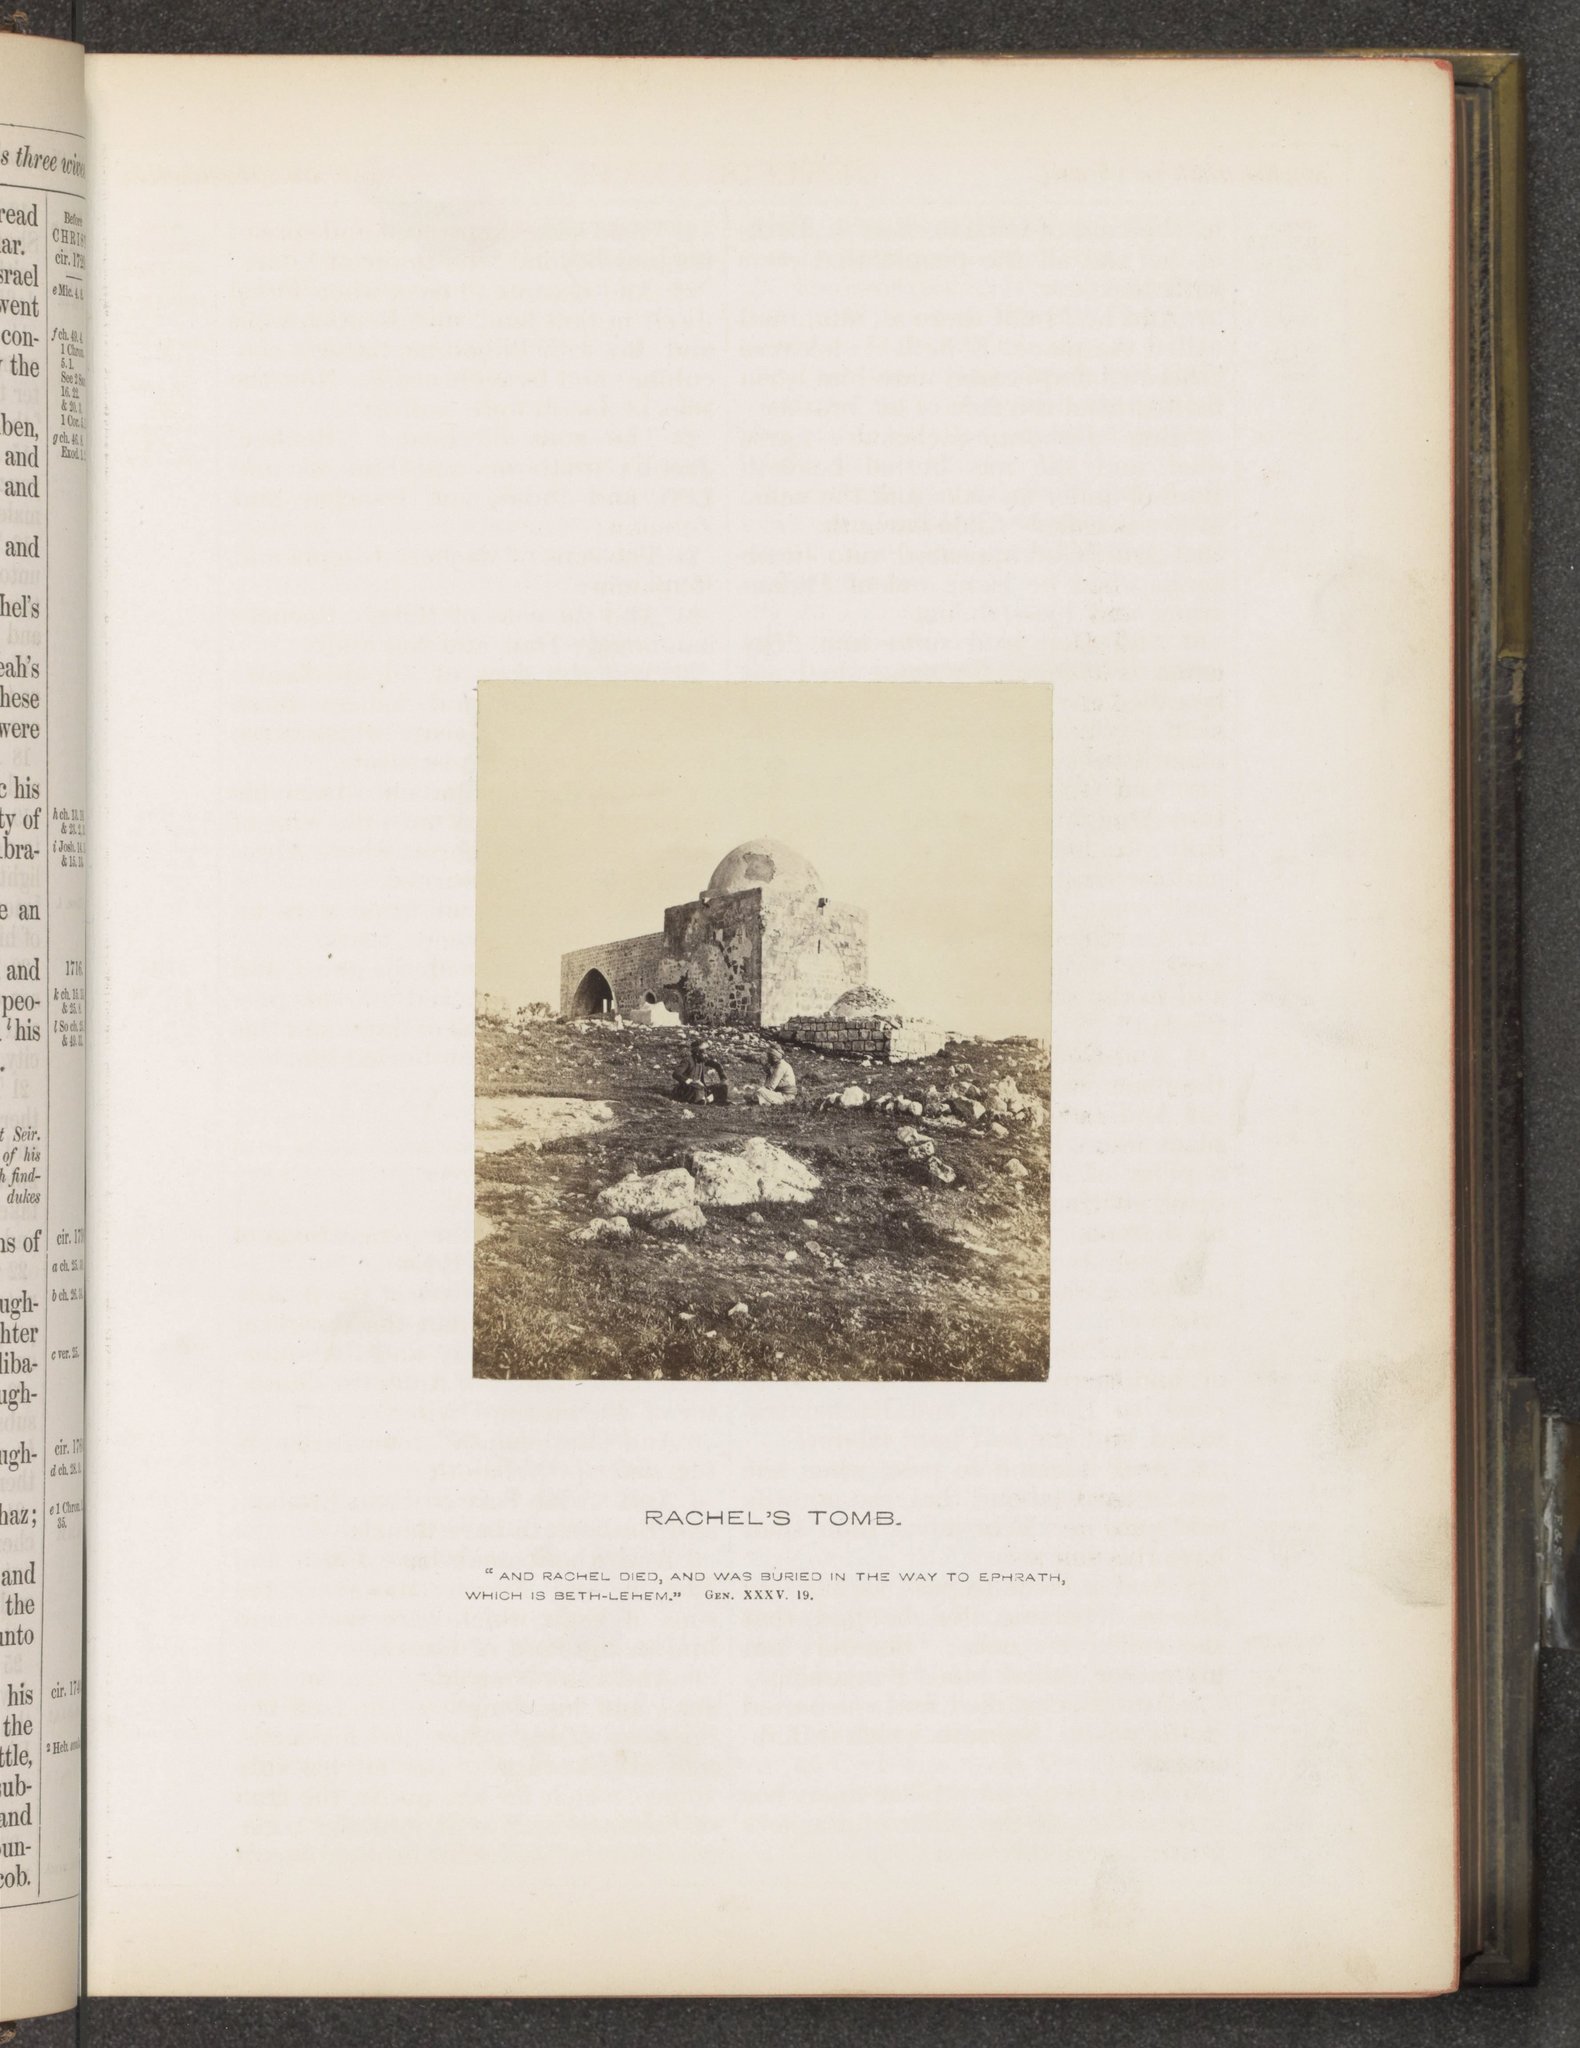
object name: page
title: Gezicht op het Graf van Rachel in Bethlehem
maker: francis frith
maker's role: publisher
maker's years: 1822-1898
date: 1850-1865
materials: photographic support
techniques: albumen print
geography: bethlehem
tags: grave, tomb, dome ~ architecture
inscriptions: inscription: ‘"And Rachel died, and was buried in the way to Ephrath, which is Beth-lehem."Gen. XXXV. 19.’